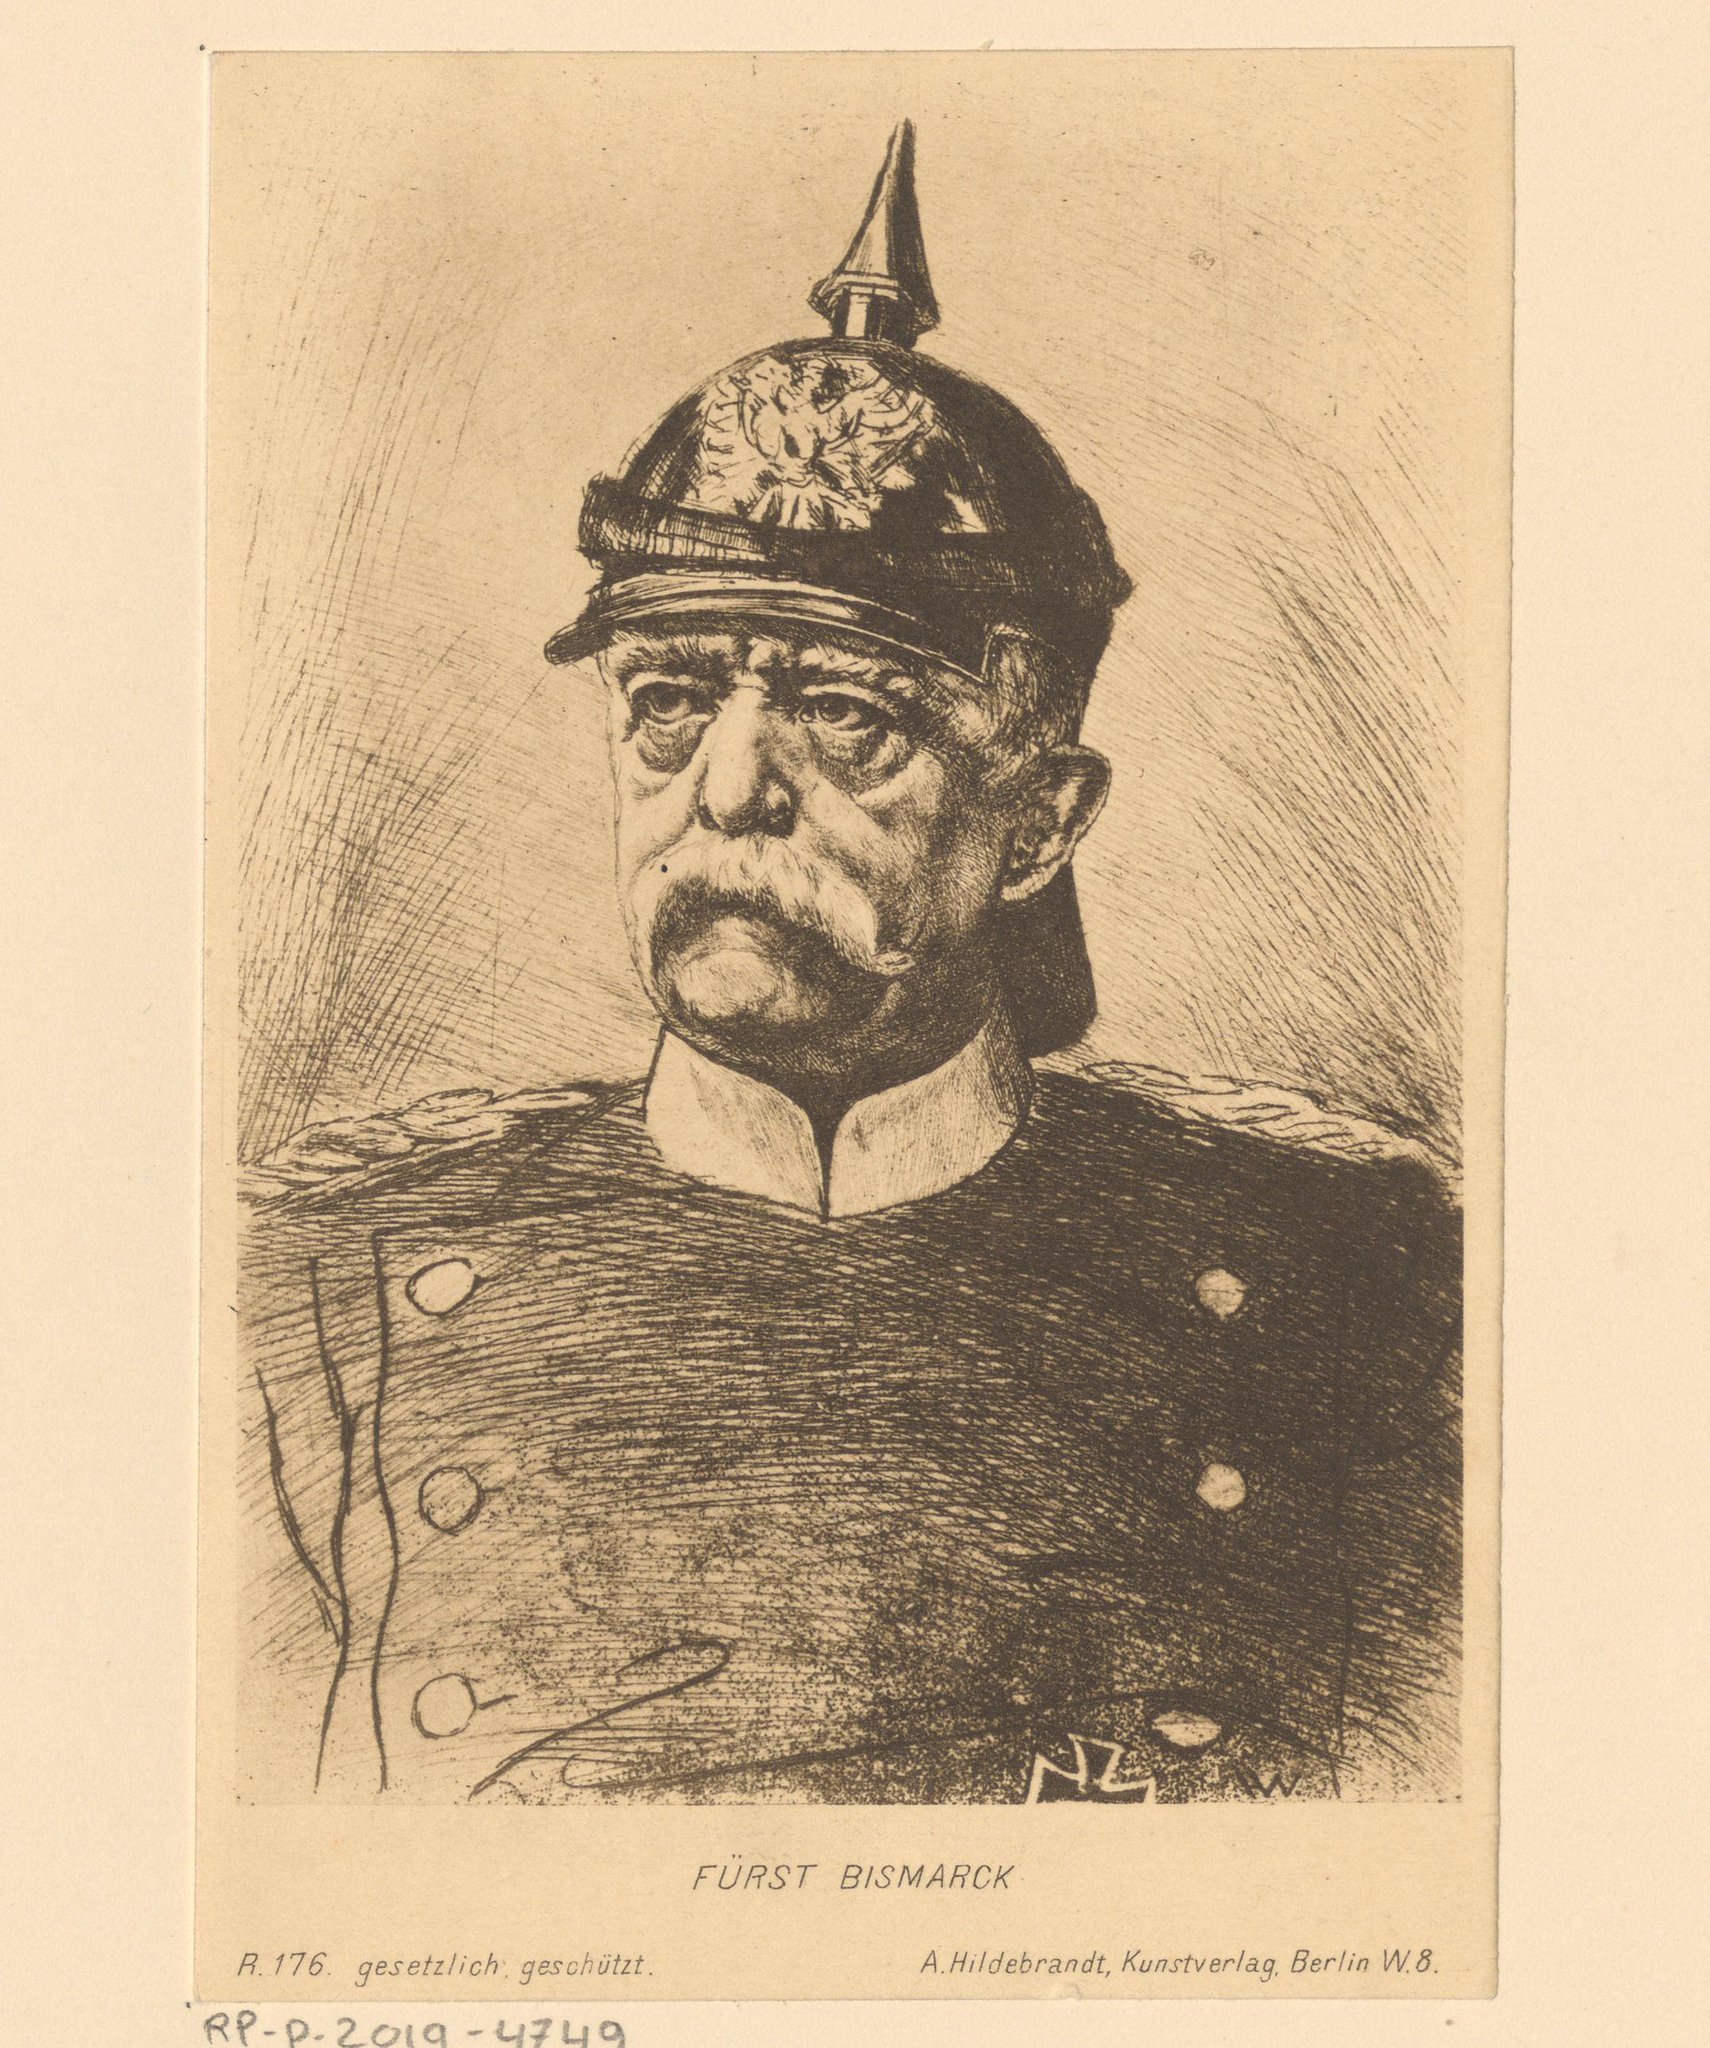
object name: print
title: Portret van Otto von Bismarck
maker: hans weyl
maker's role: painter, print maker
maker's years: 1863-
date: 1890-1899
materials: paper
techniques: drypoint, etching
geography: berlin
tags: helmet, historical persons